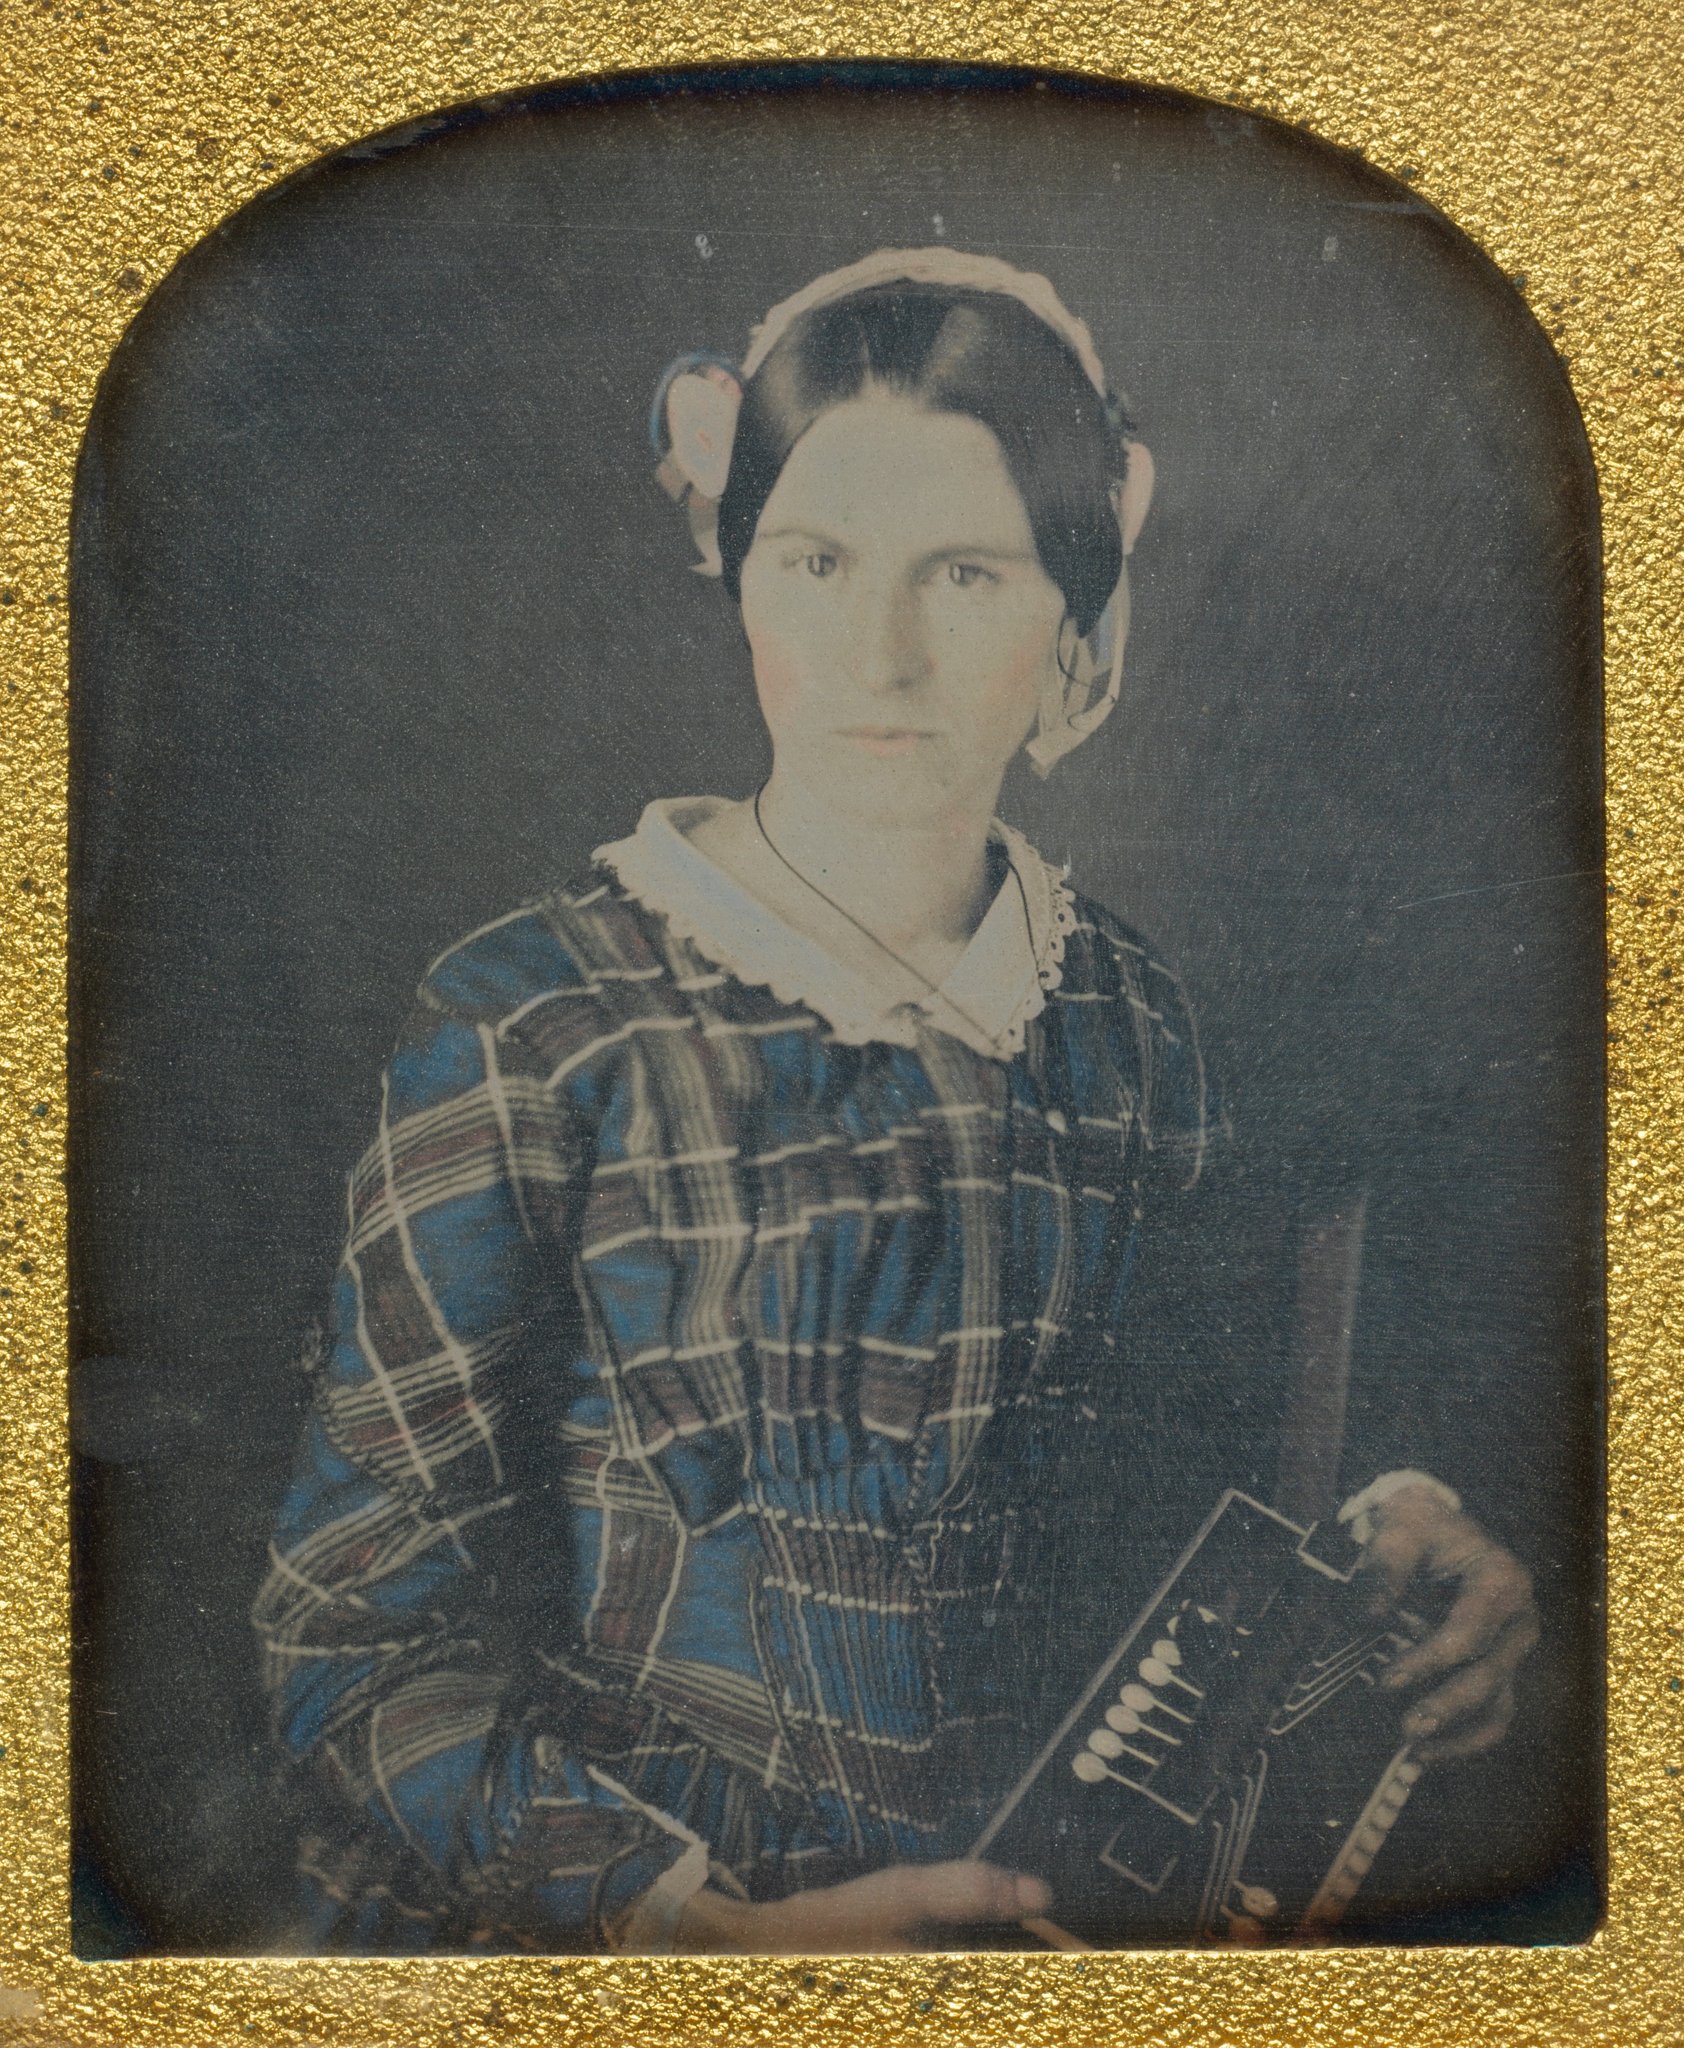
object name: daguerreotype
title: Woman with an Accordion daguerreotype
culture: american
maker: ron fasand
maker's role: artist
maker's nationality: american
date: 1840-1849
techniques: daguerreotype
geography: united states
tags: portraits,women,accordions